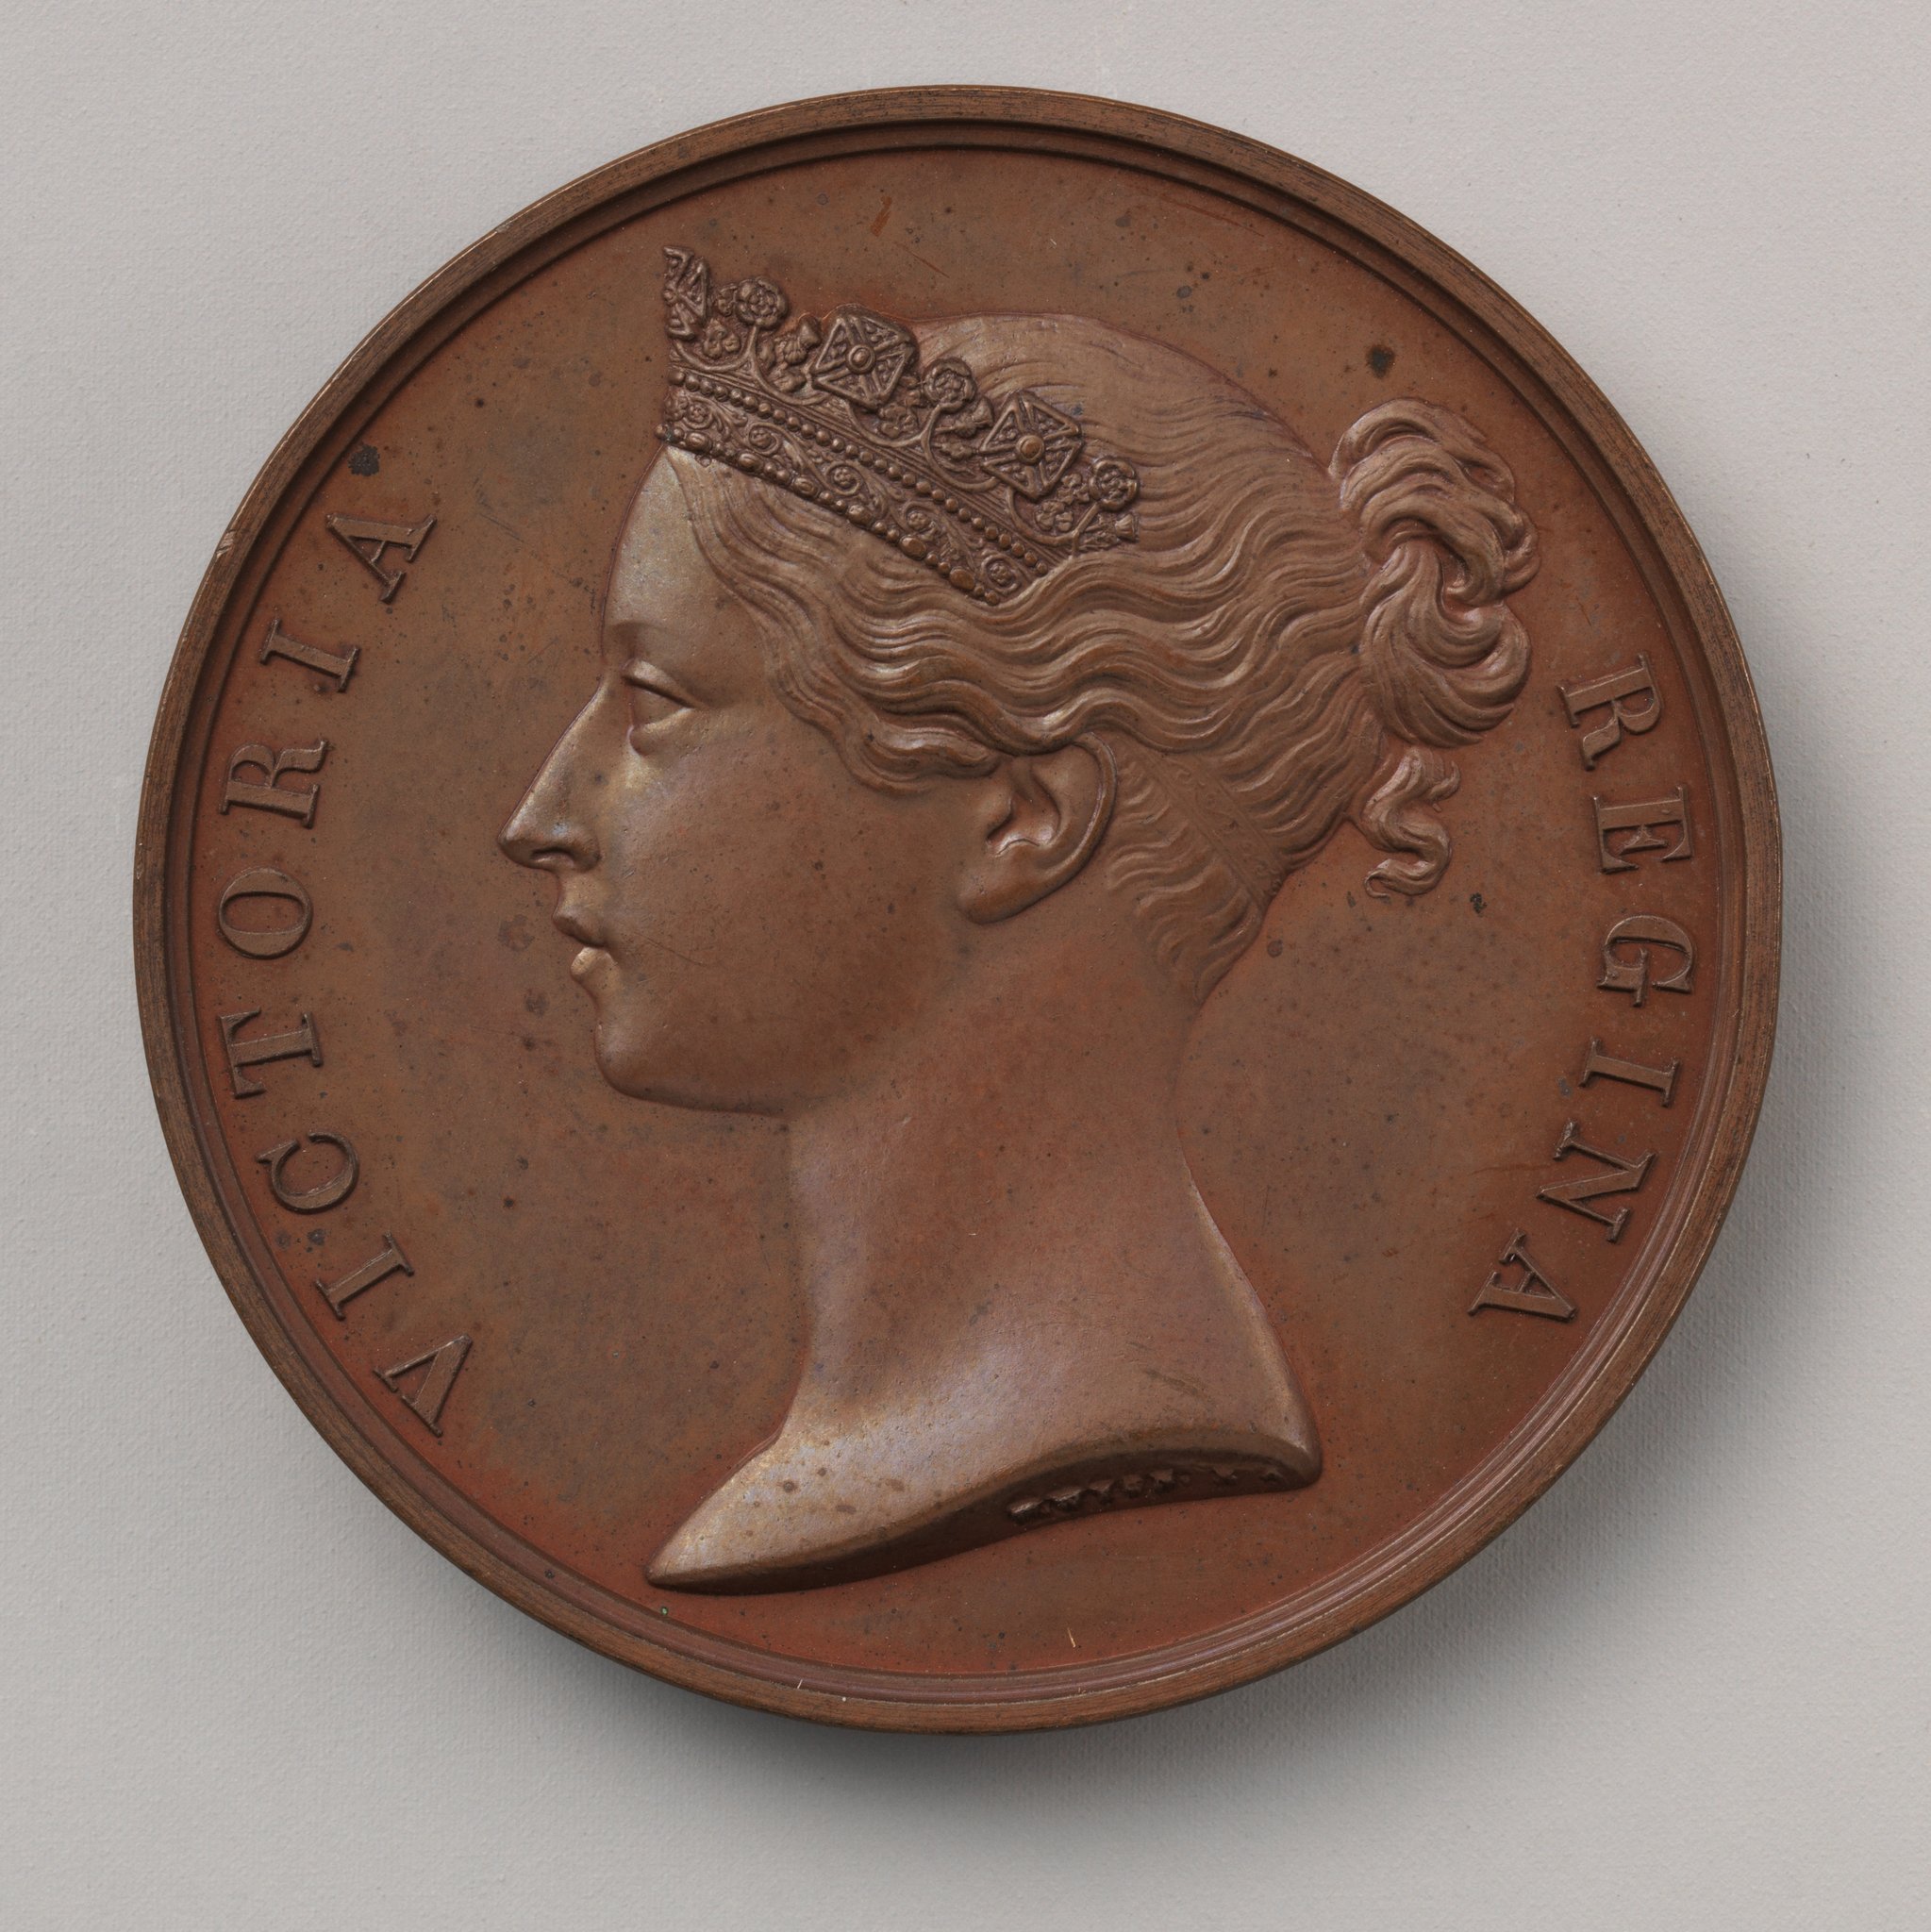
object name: medal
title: The Sutlej Medal (1845-6)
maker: william wyon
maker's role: artist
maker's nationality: british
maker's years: 1795-1851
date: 1845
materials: bronze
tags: profiles,women,queen victoria